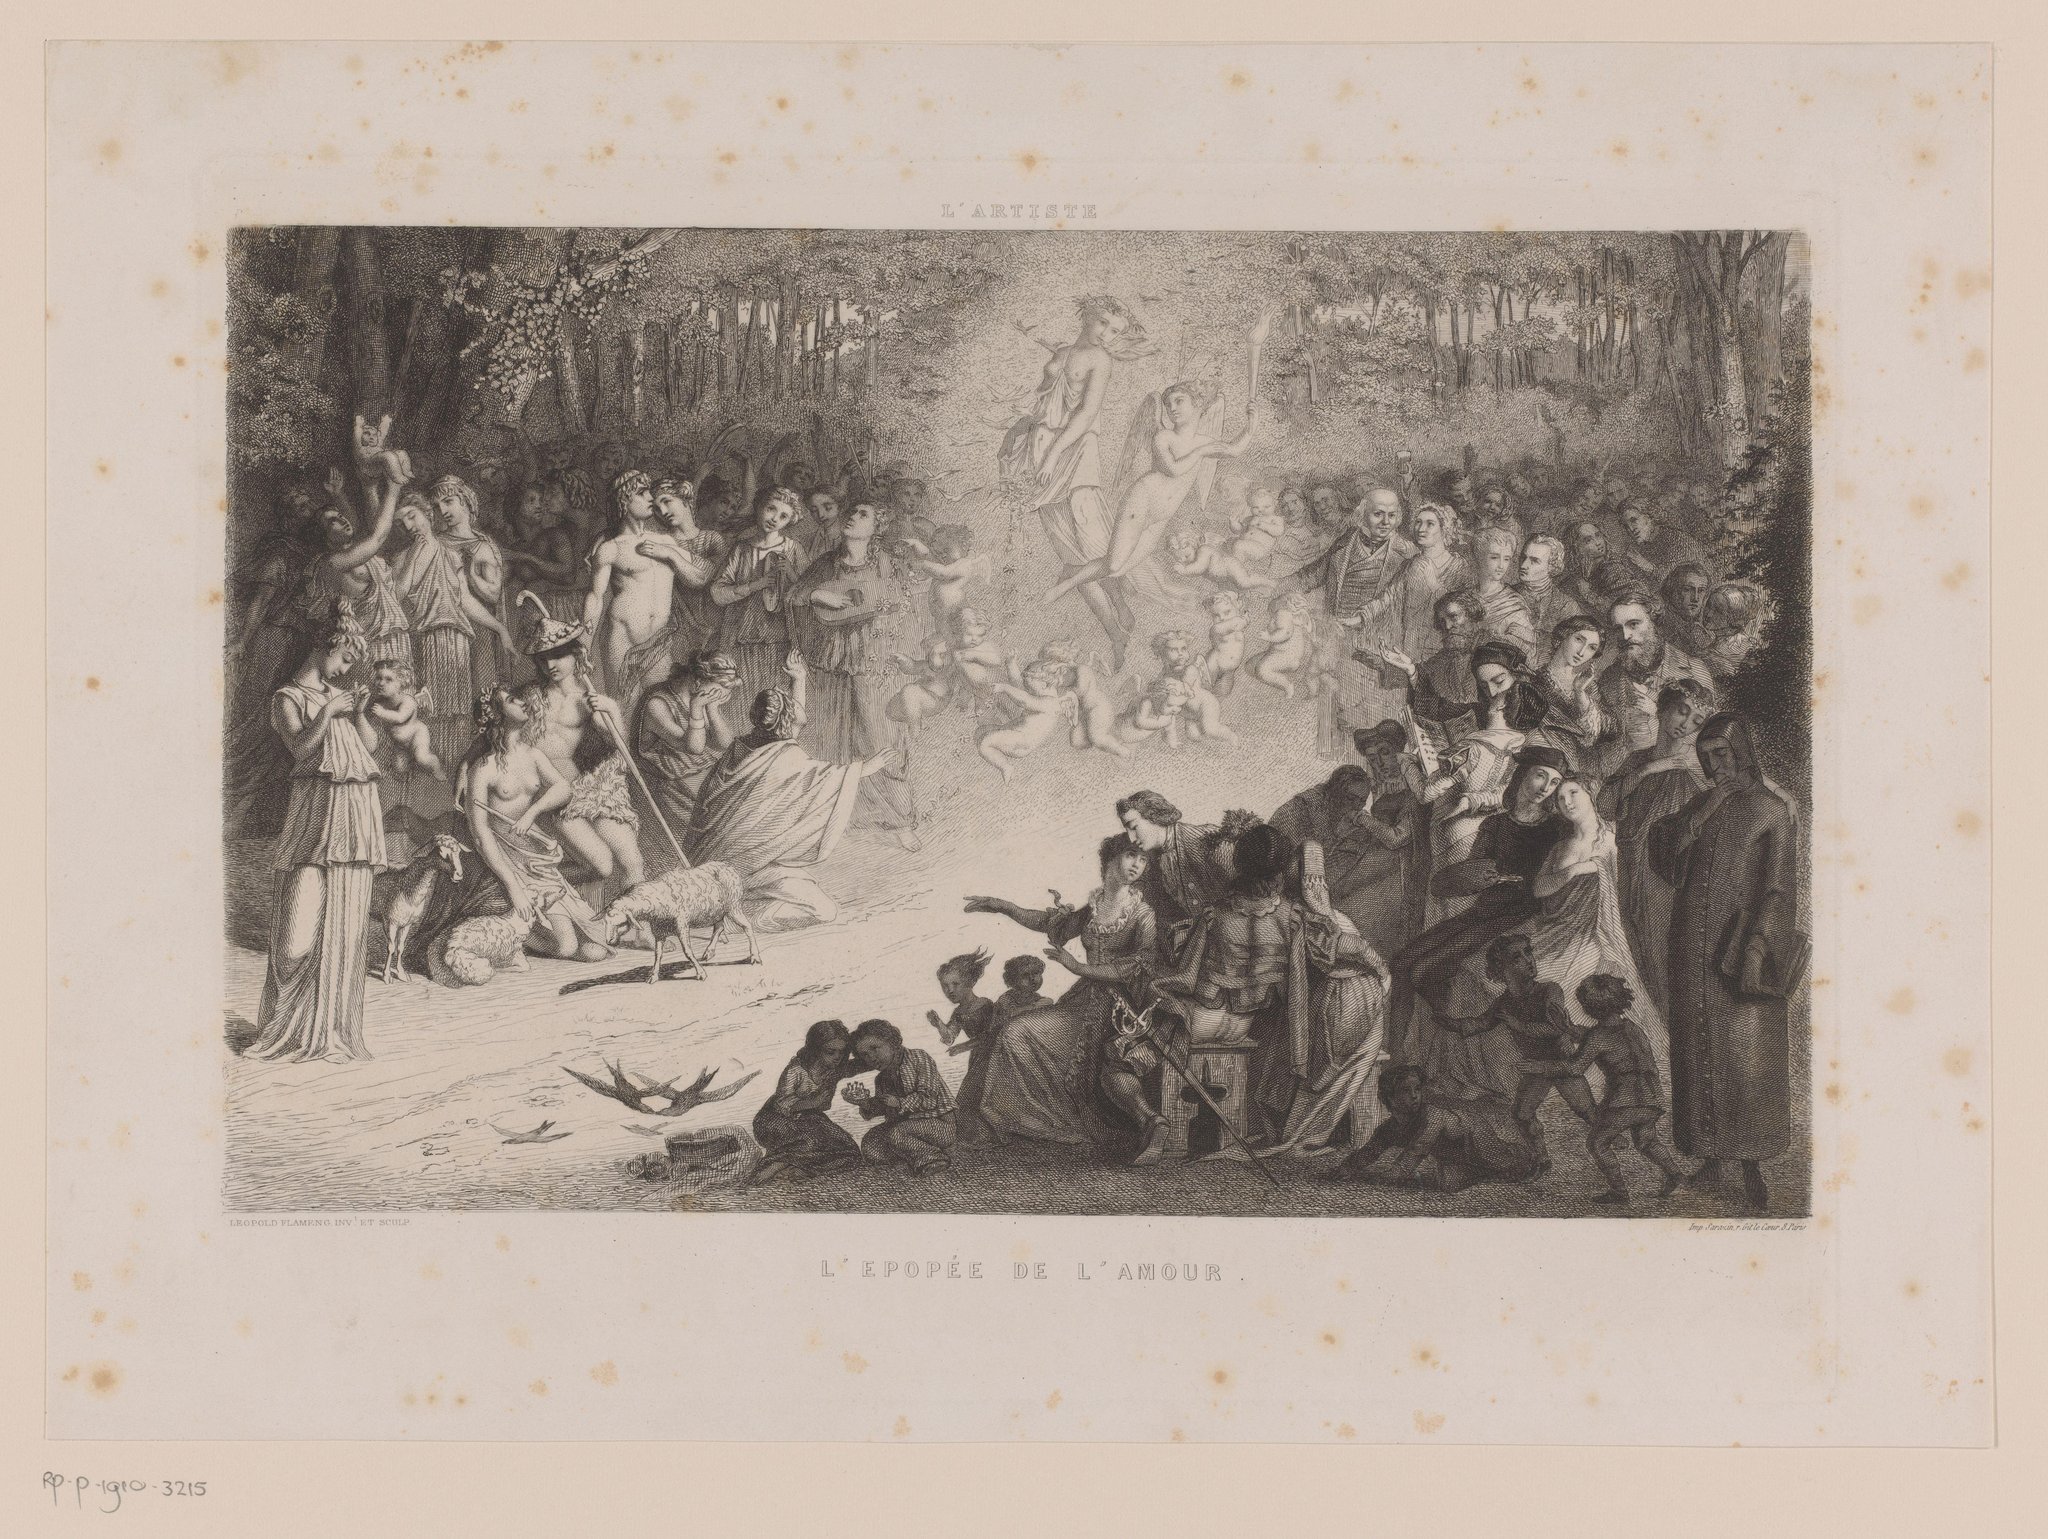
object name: print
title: L'epopée de l'amour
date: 1856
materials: paper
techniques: etching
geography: paris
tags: lovers; courting, flirting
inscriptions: collector's mark: Lugt 2228, collector's mark: Lugt 1377, collector's mark: Lugt 1485